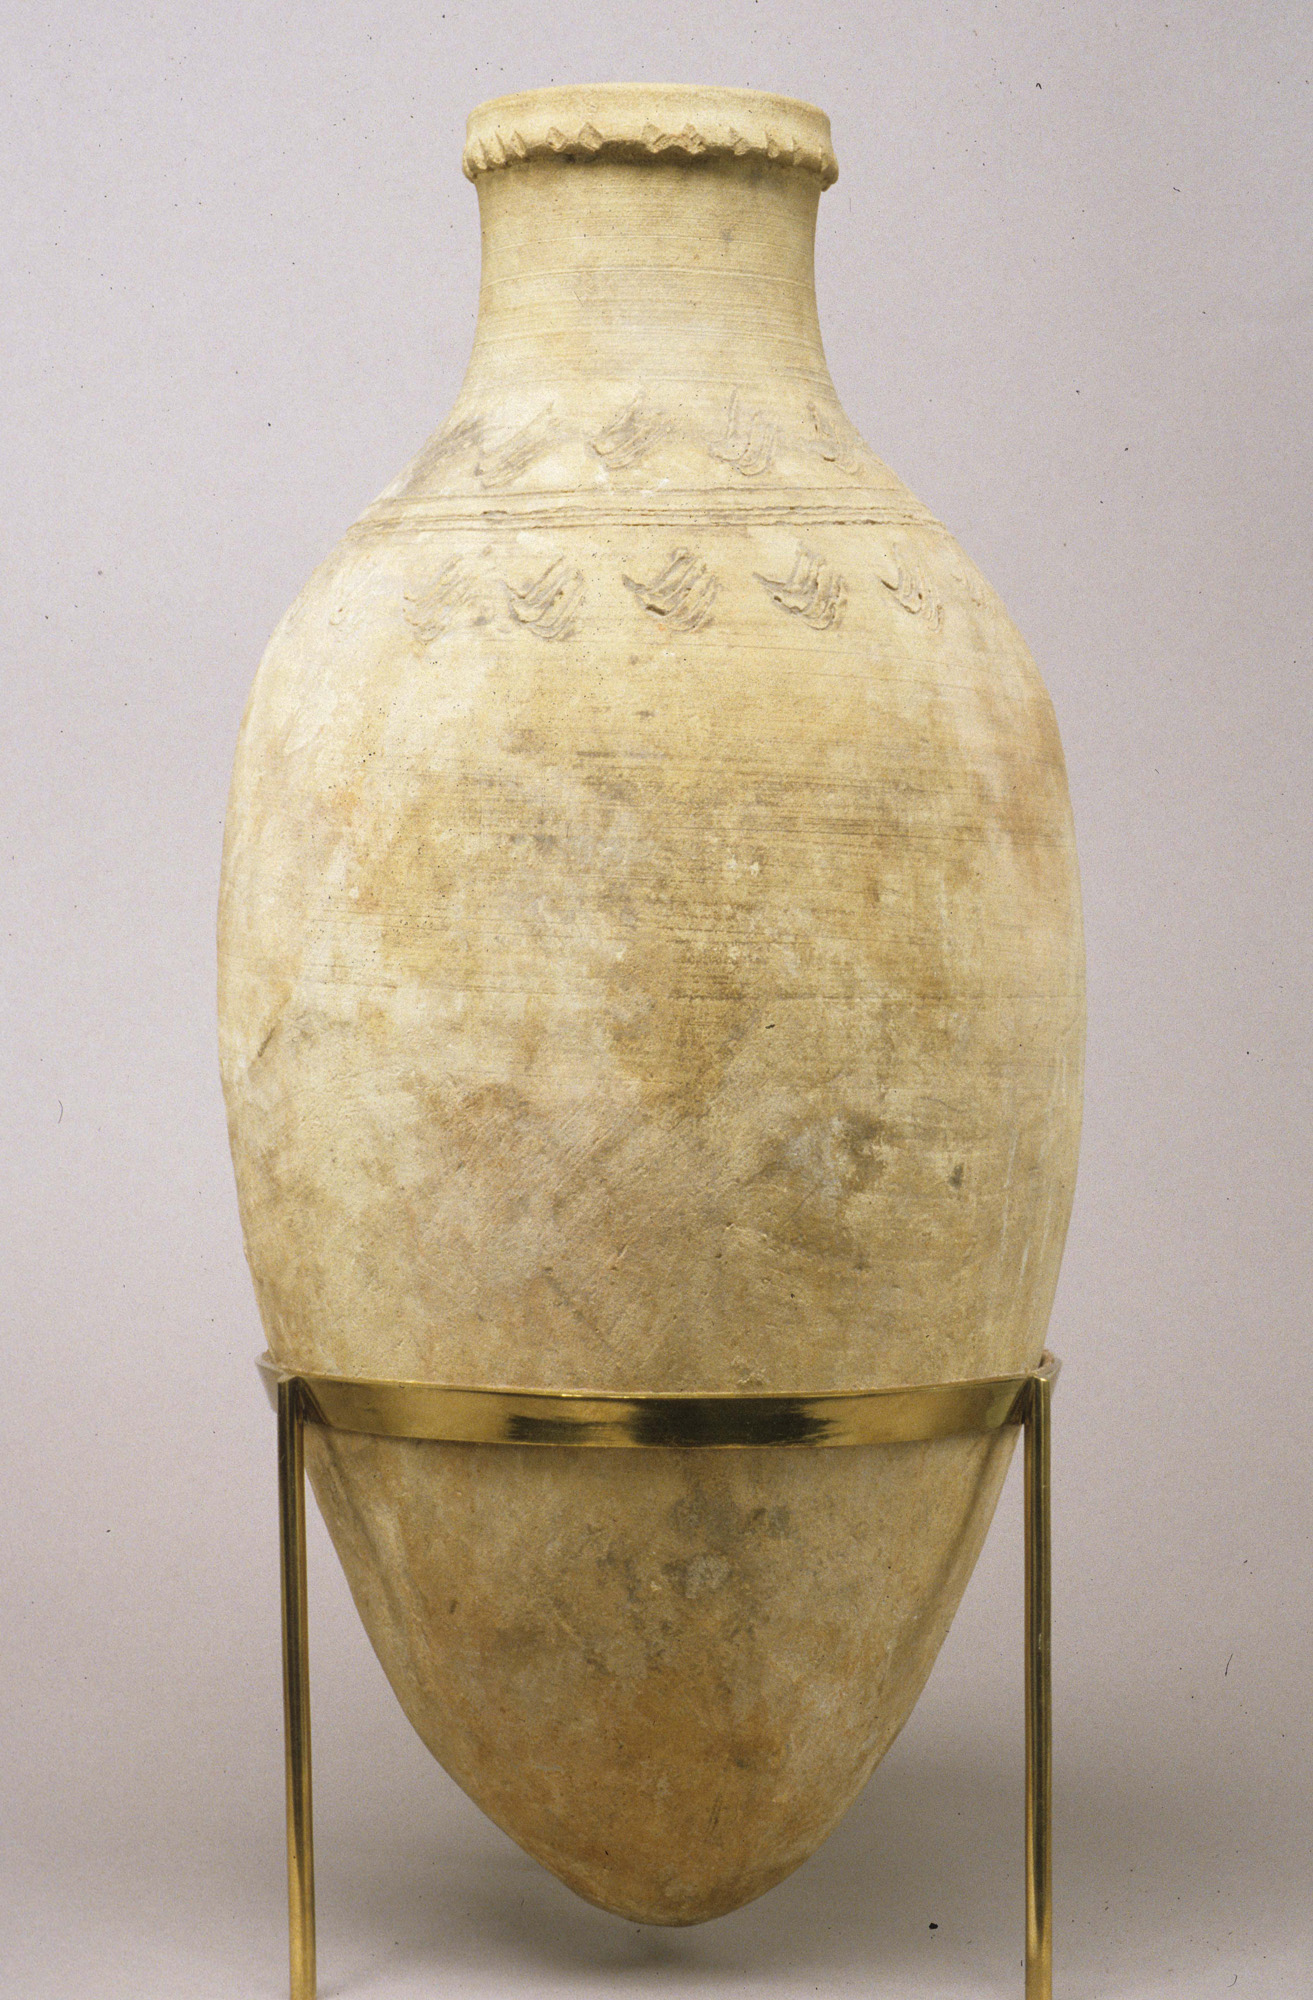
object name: jar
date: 1640-1504 BCE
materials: pottery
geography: egypt